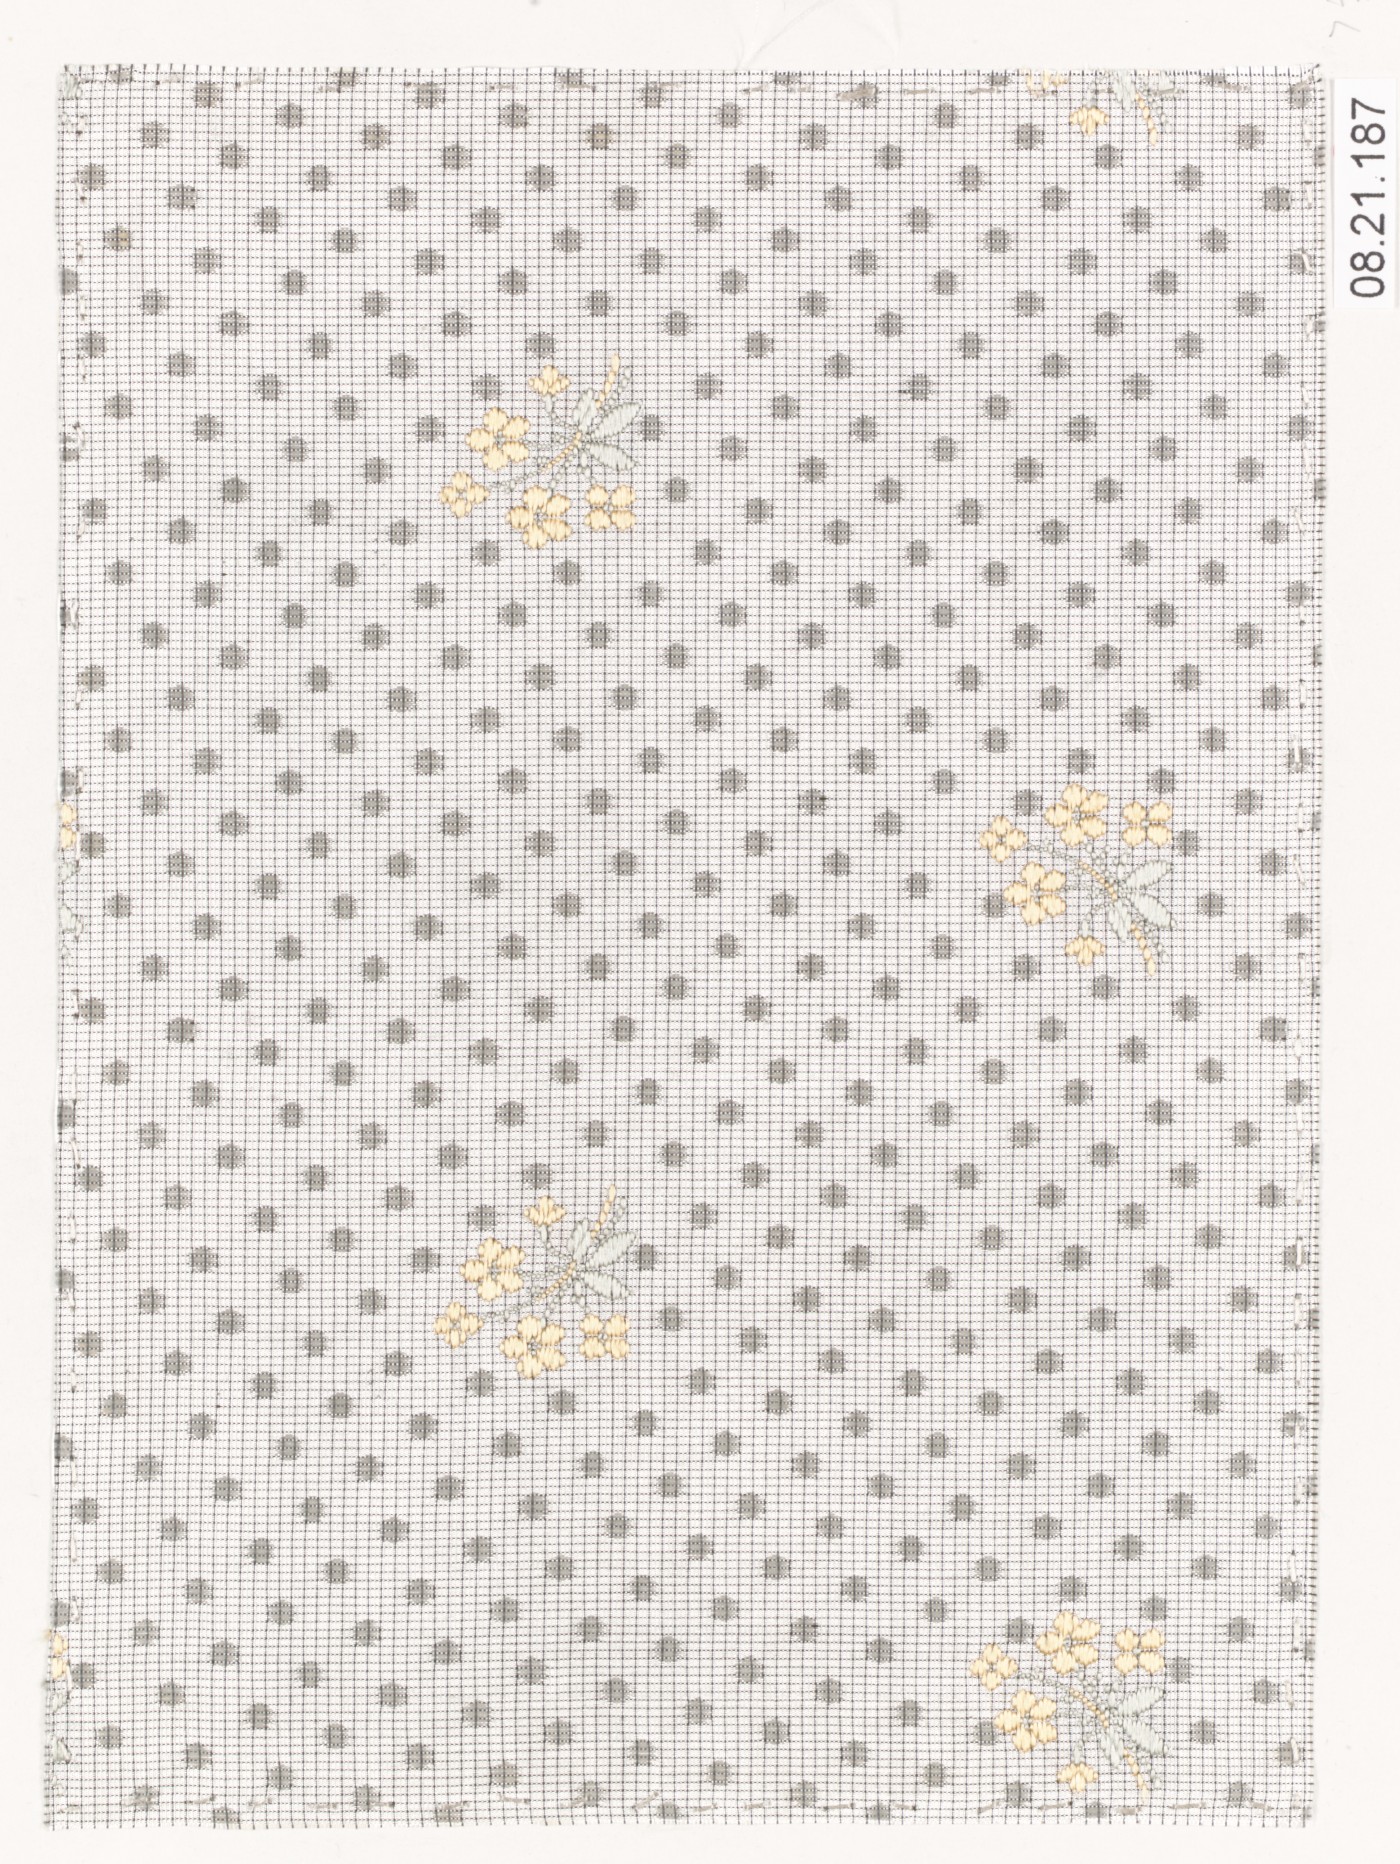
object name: textile sample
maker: Anonymous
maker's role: designer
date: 1900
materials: silk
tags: flowers